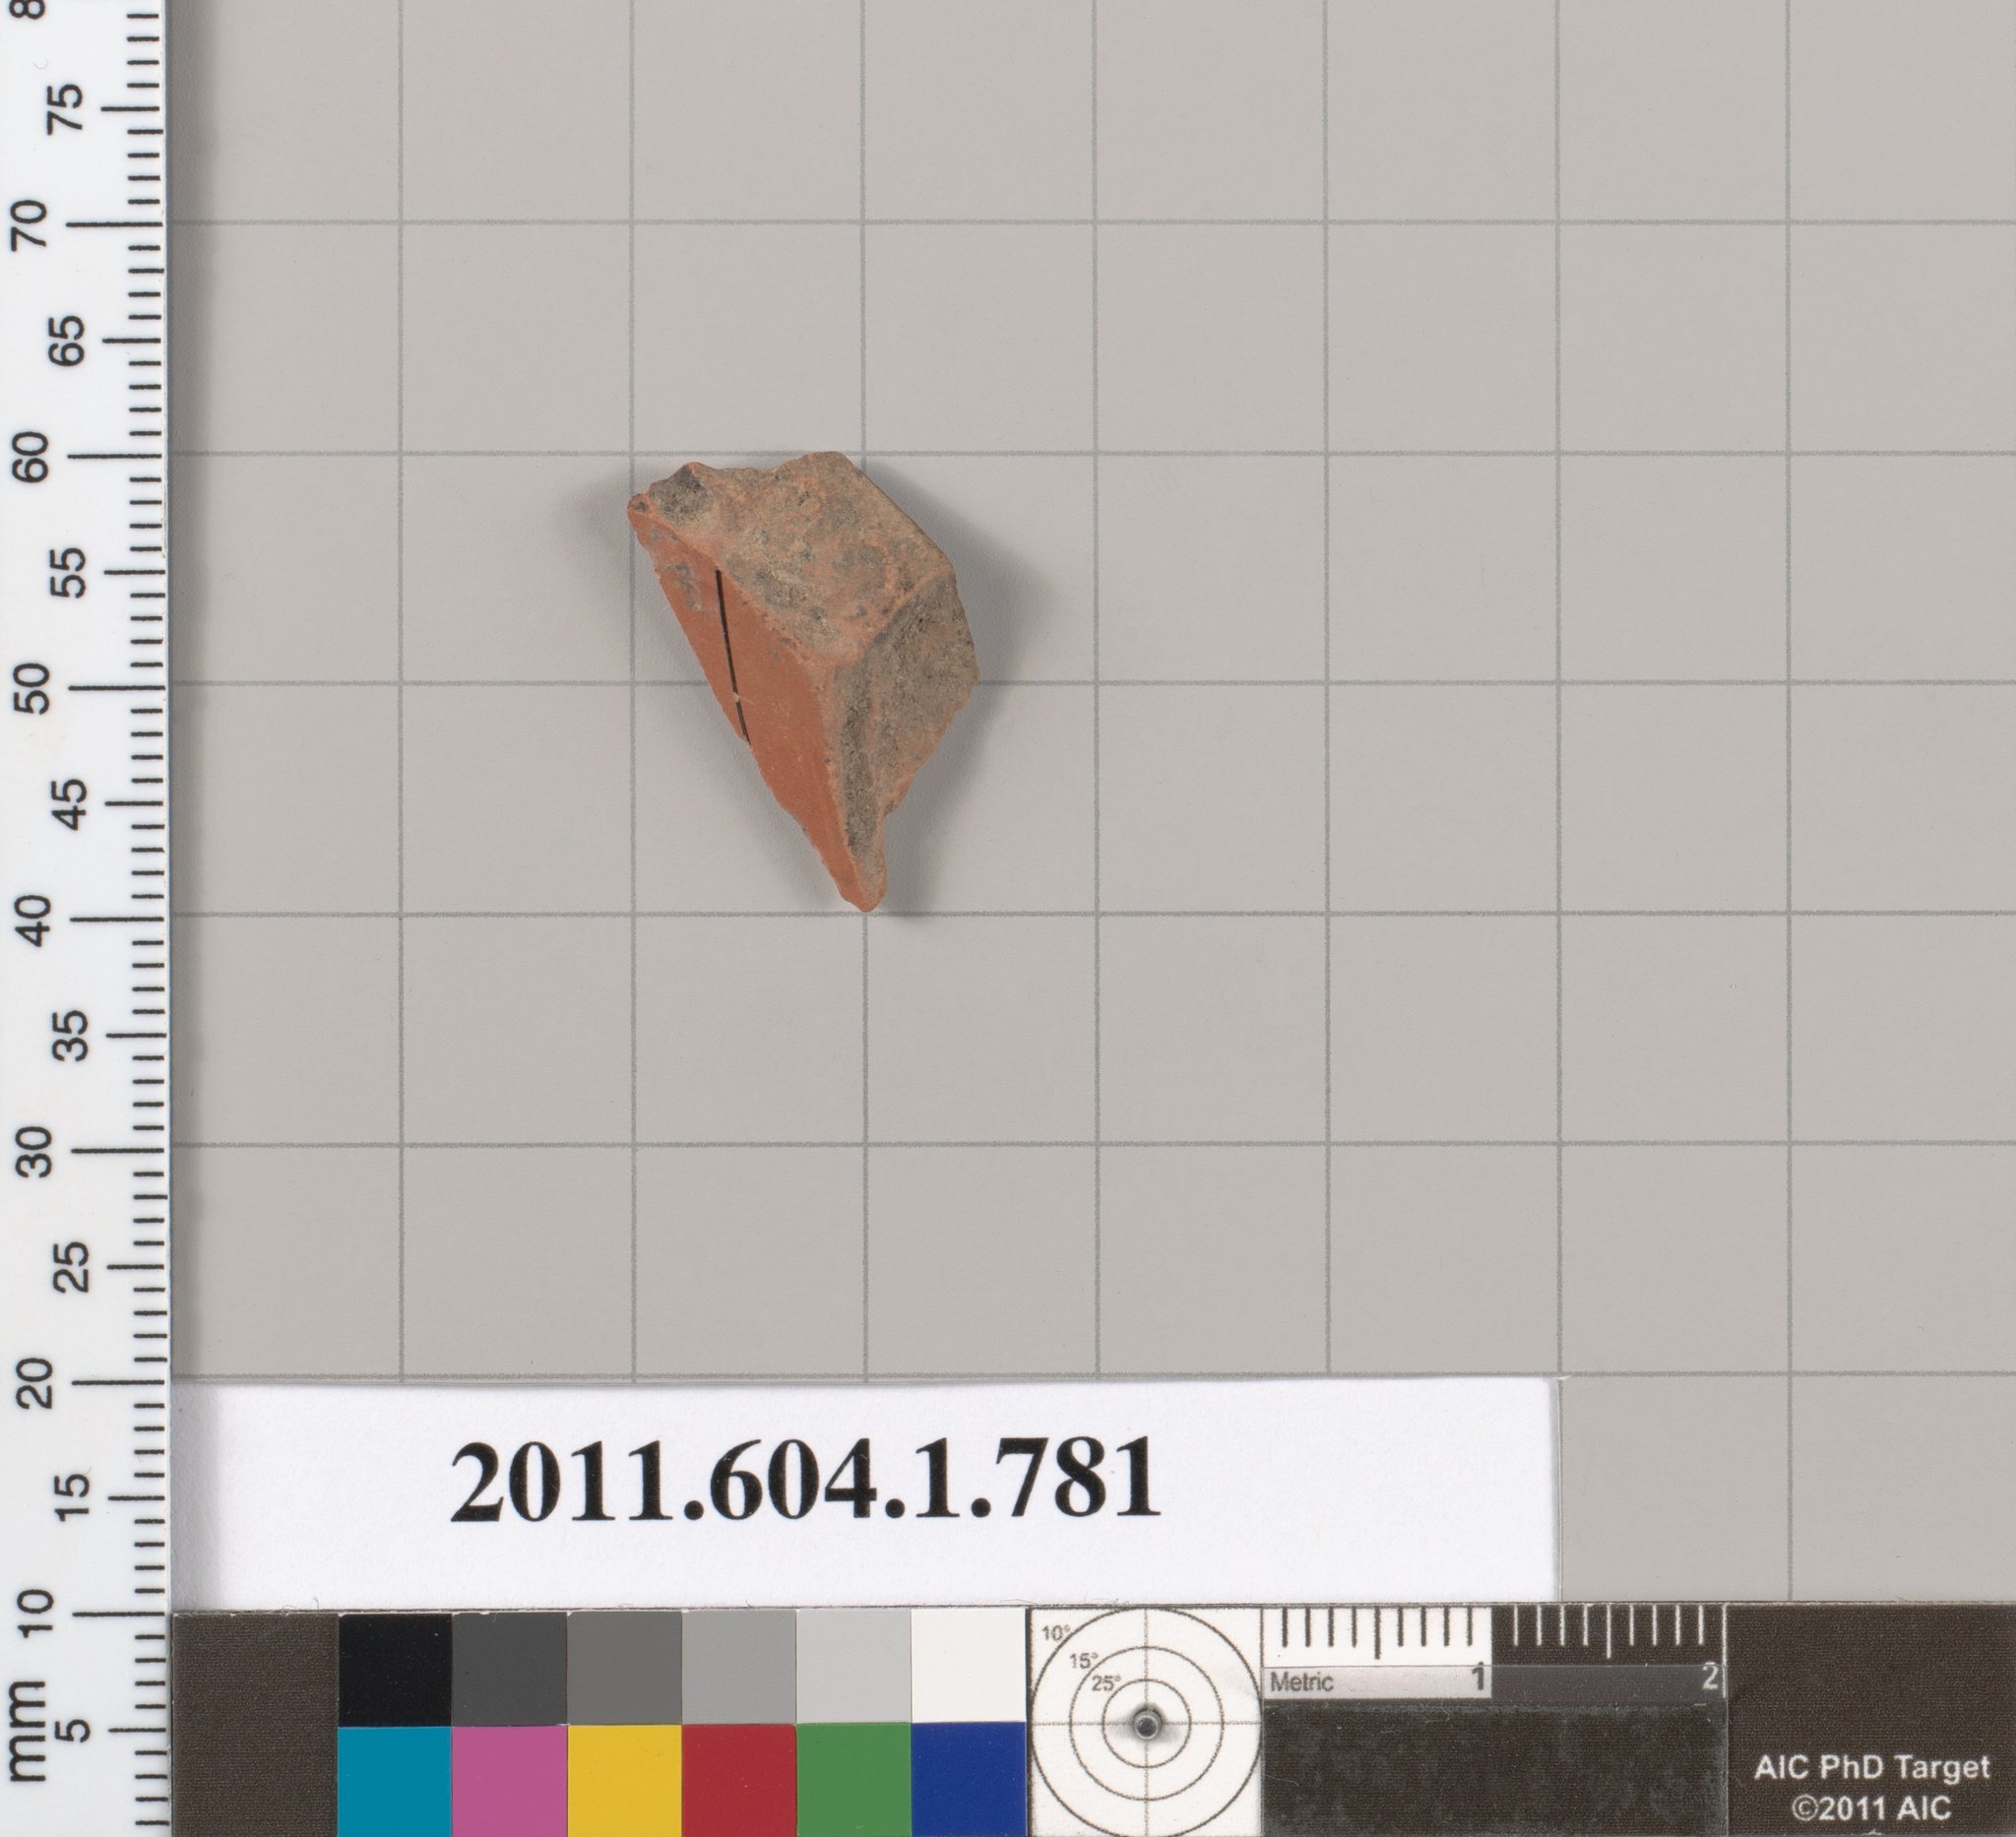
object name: kylix fragment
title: Terracotta fragment of a kylix (drinking cup)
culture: greek, attic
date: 475-451 BCE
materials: terracotta